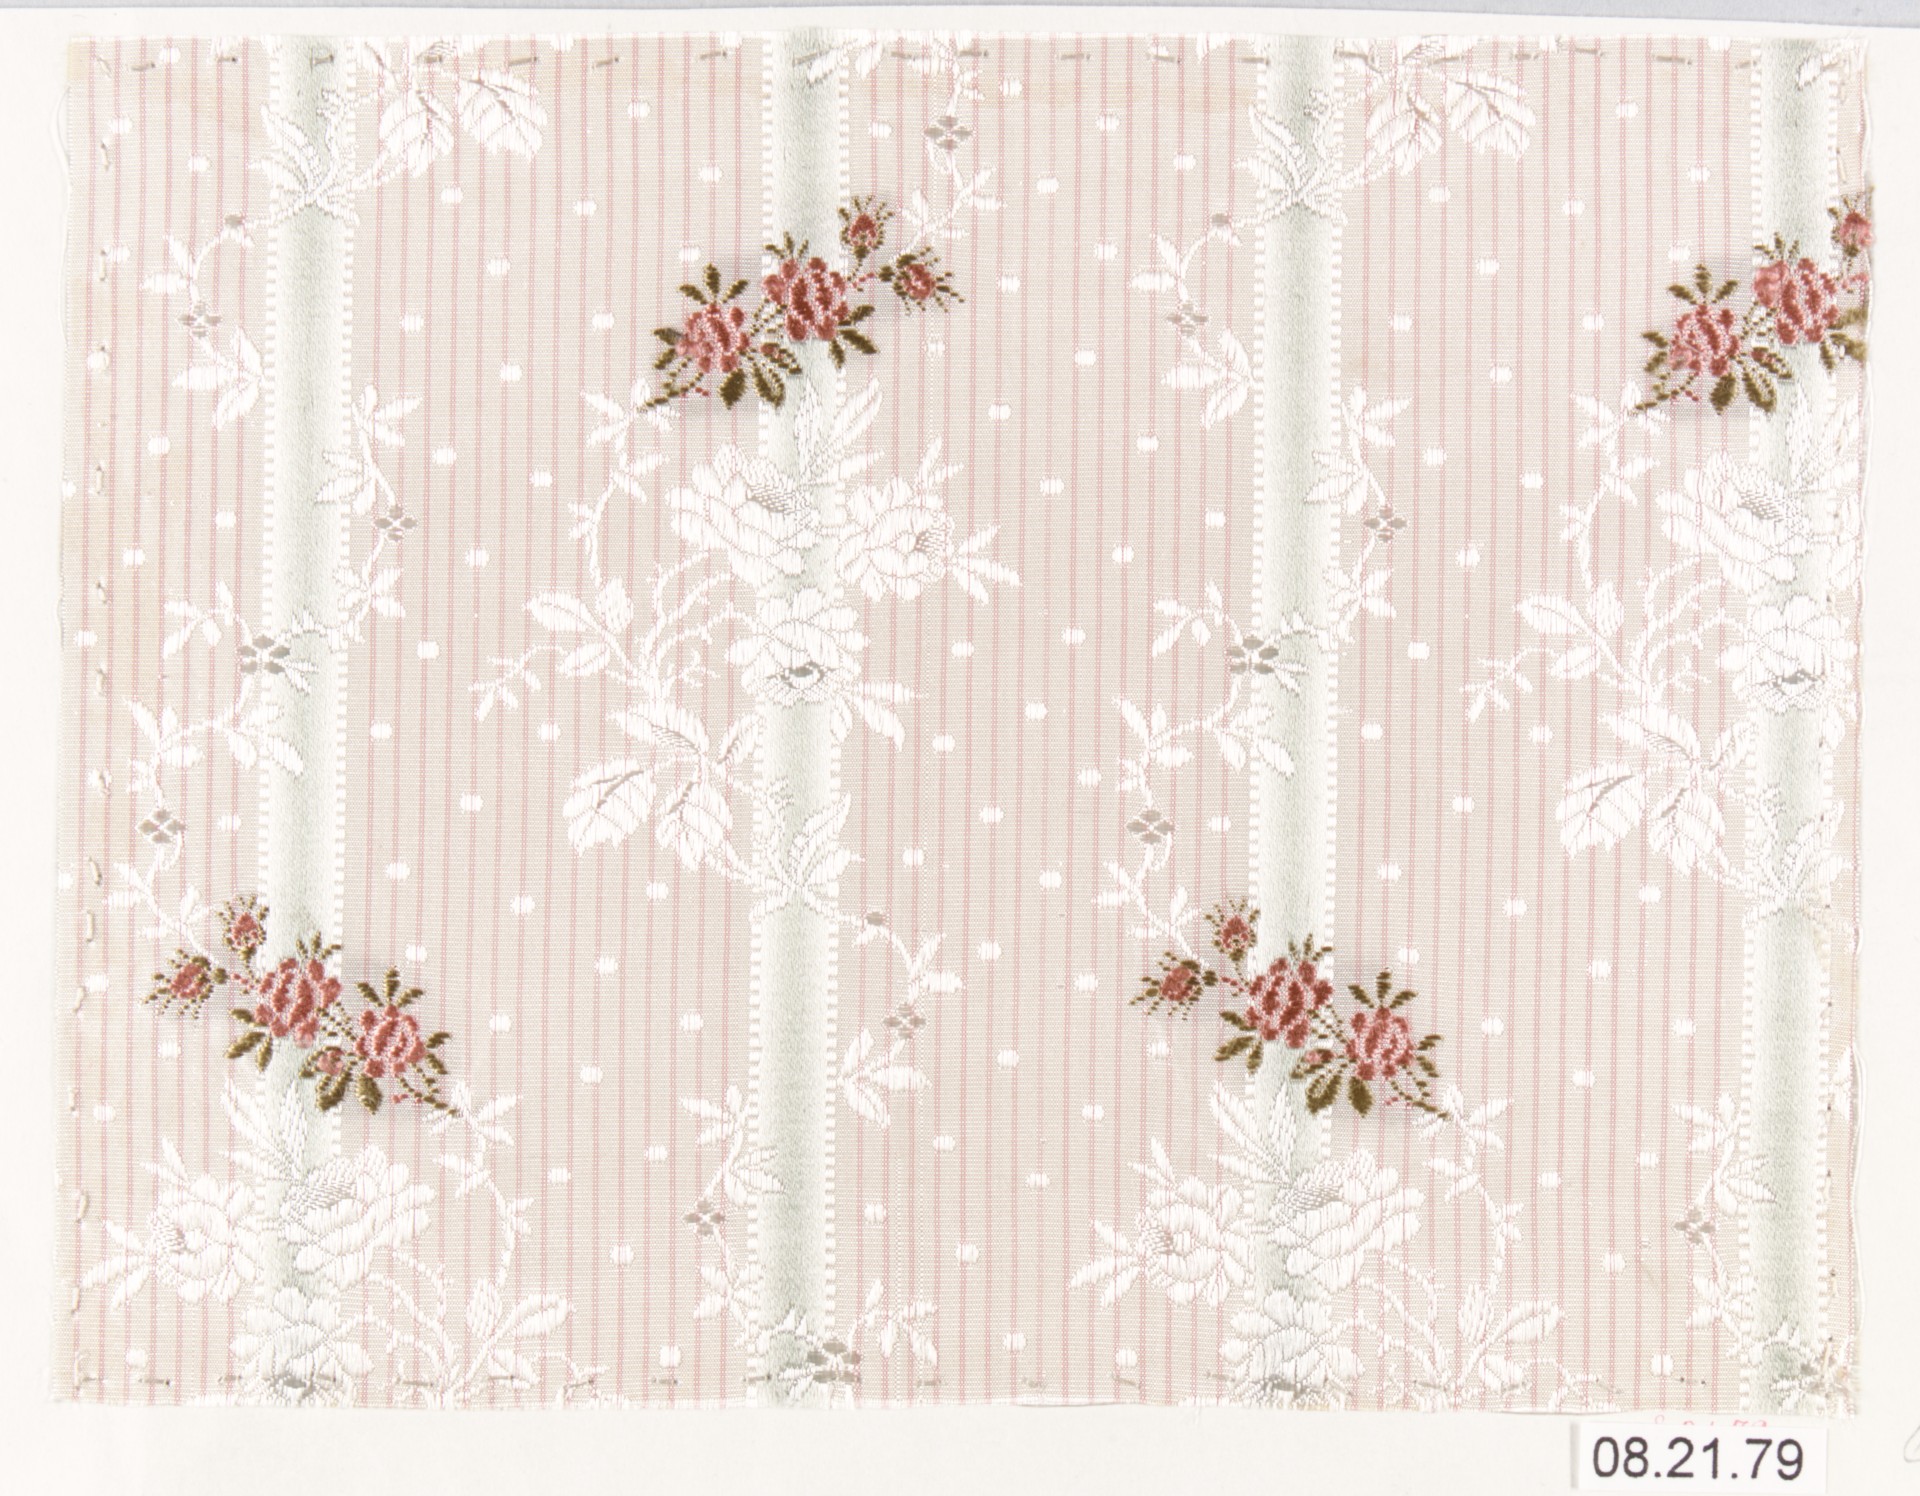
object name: textile sample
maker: Anonymous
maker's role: designer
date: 1900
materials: silk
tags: flowers